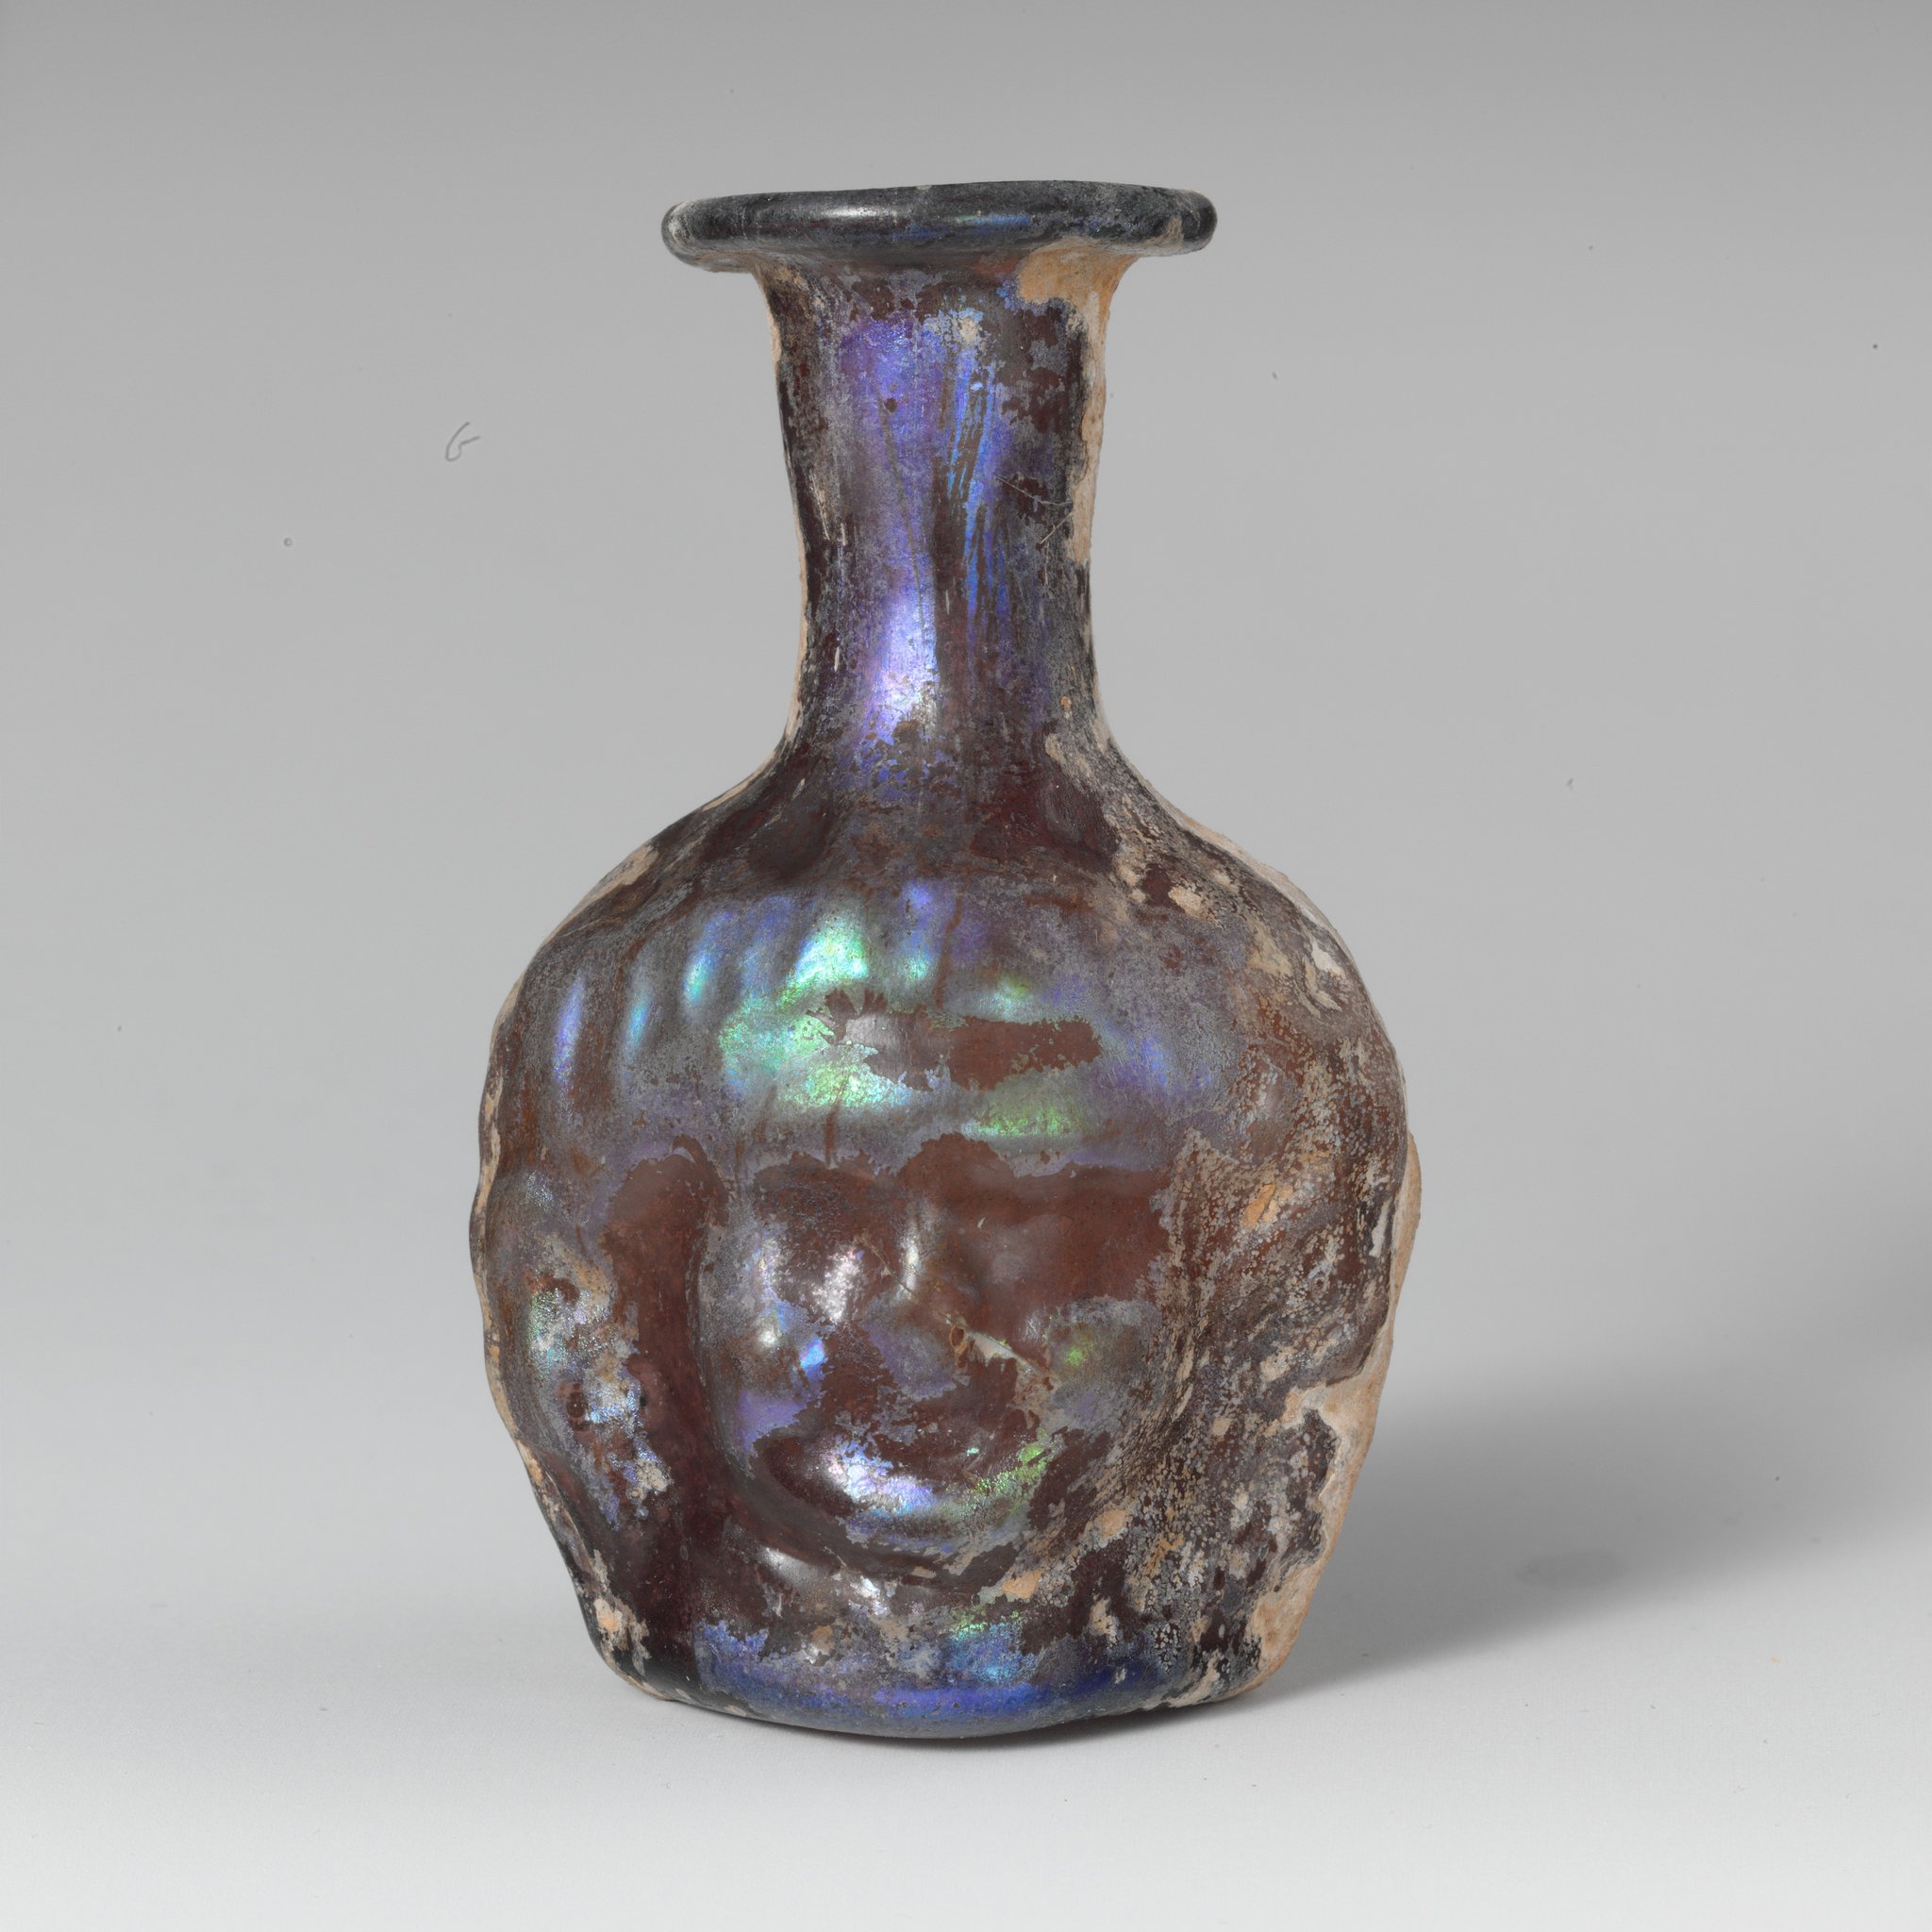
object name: flask, double head shaped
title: Glass double head-shaped flask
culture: roman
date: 201-300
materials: glass